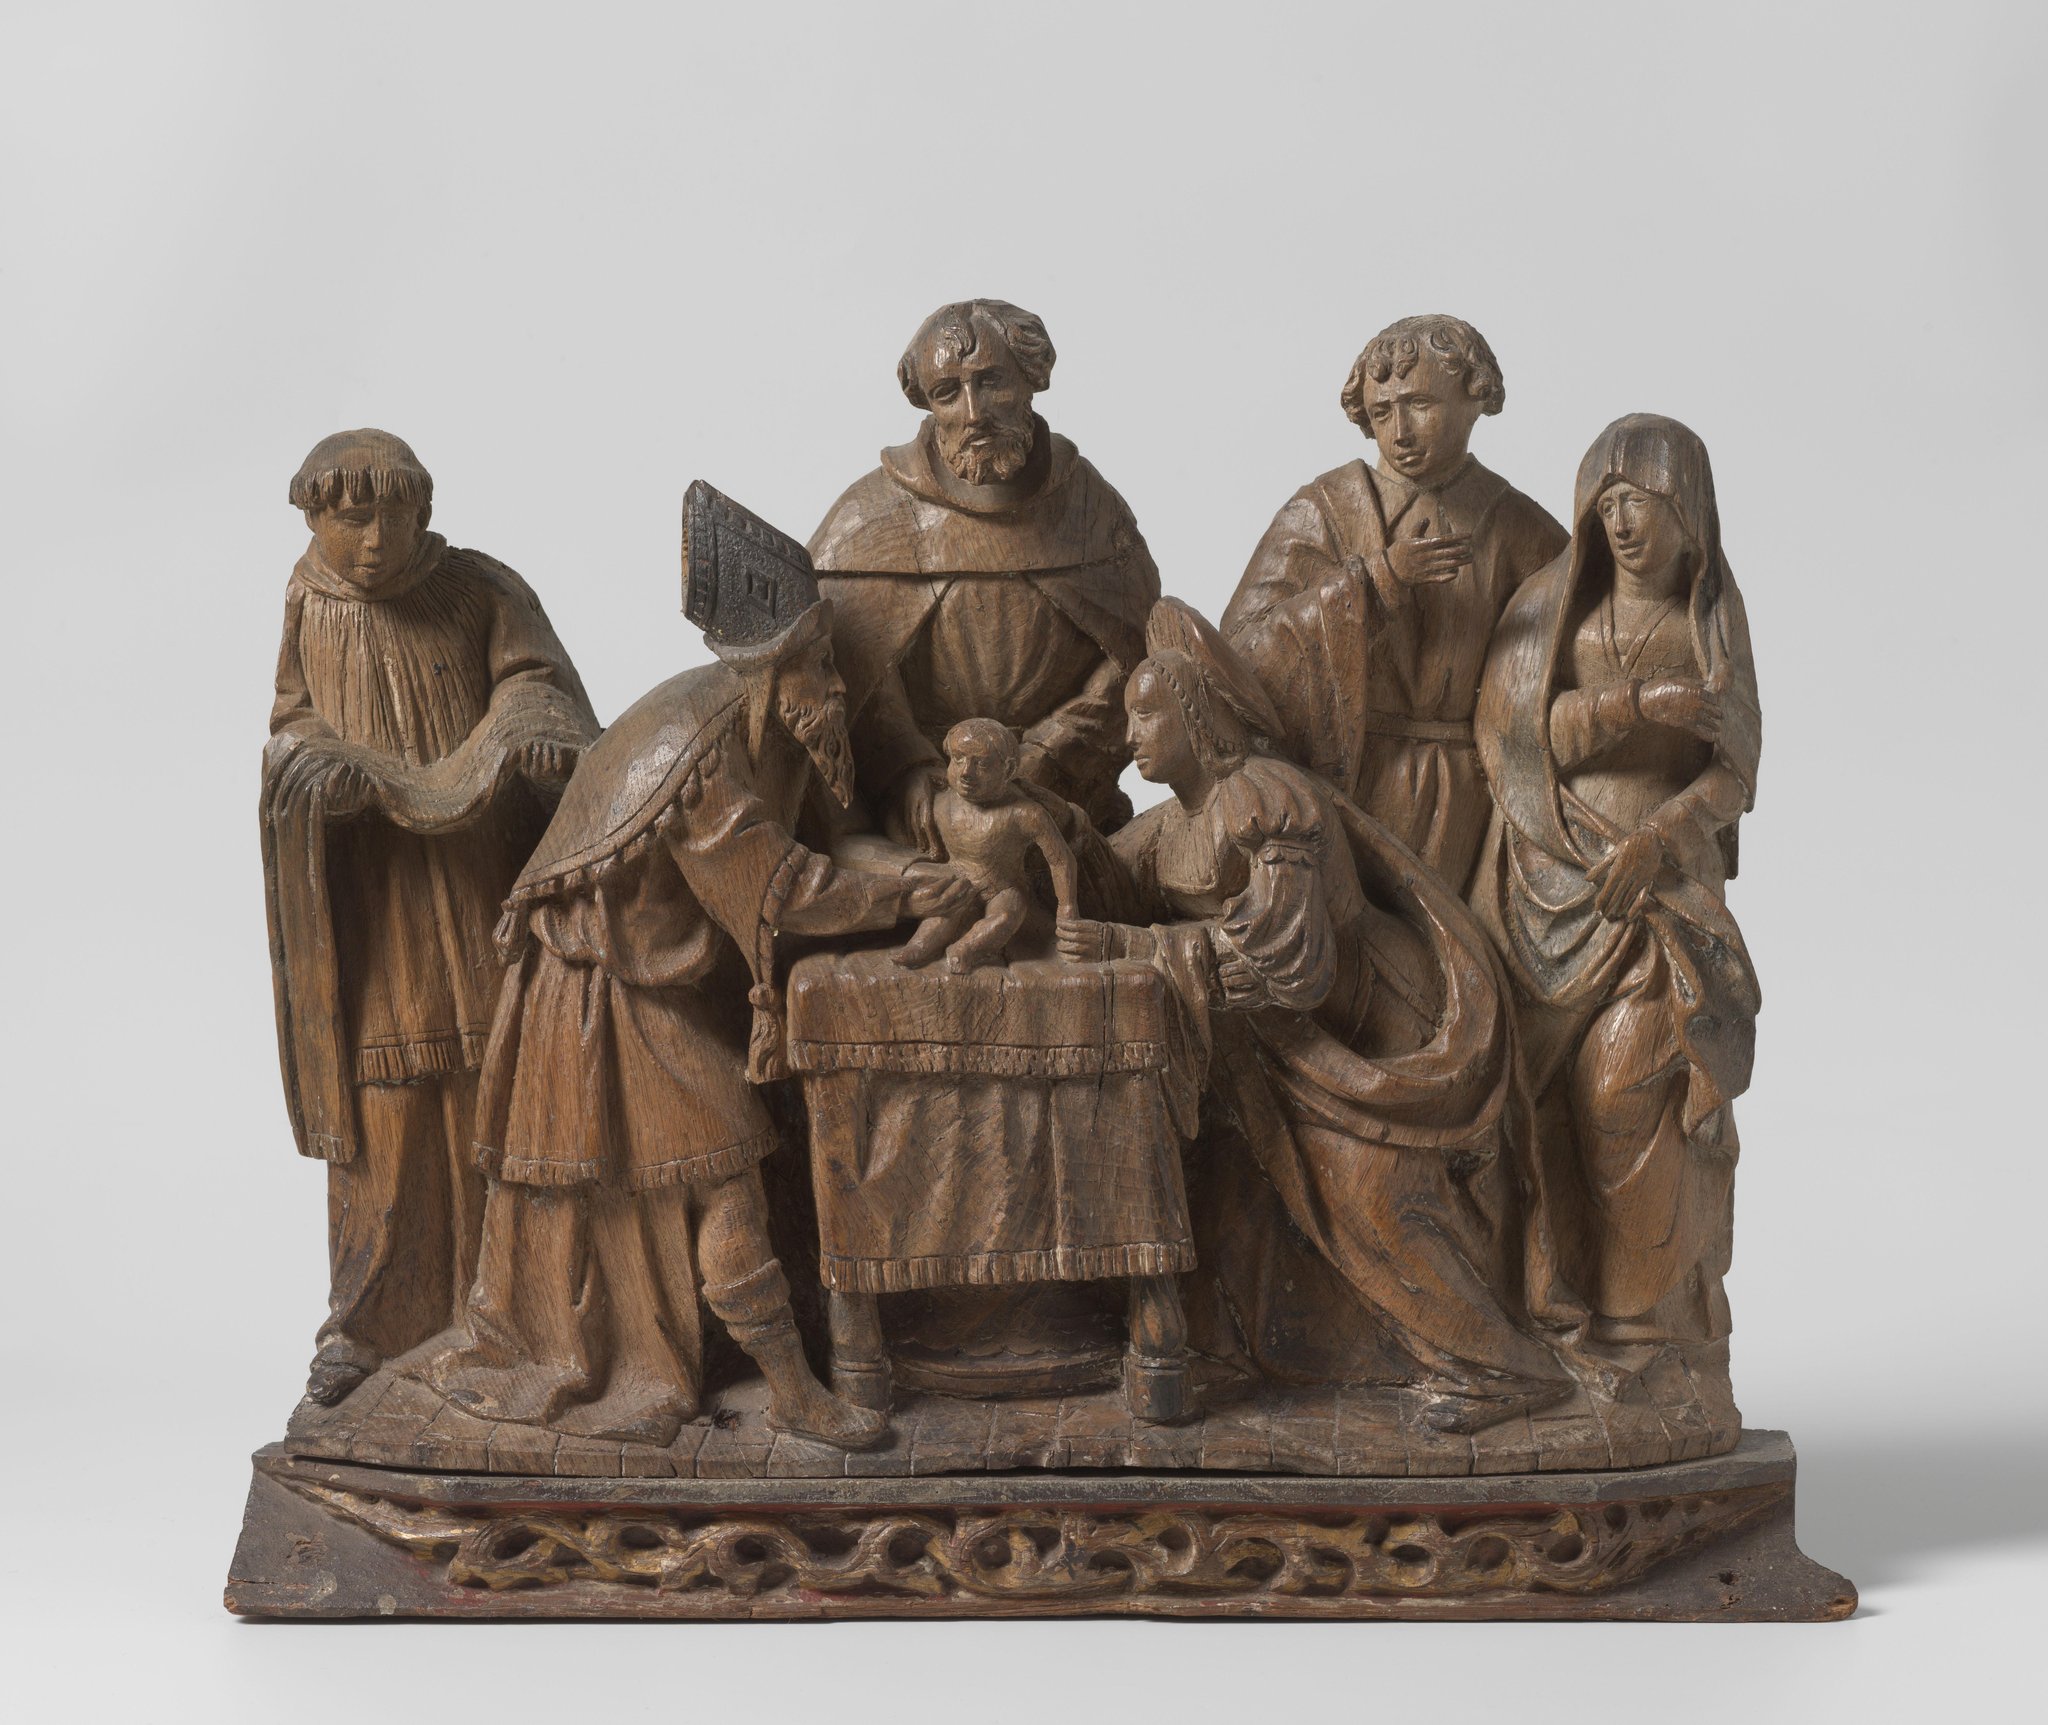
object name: sculpture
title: The Circumcision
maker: jan van velthoven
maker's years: -1557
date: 1540-1550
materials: wood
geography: breda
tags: circumcision of the christ-child by the priest in the temple (luke 2:21)